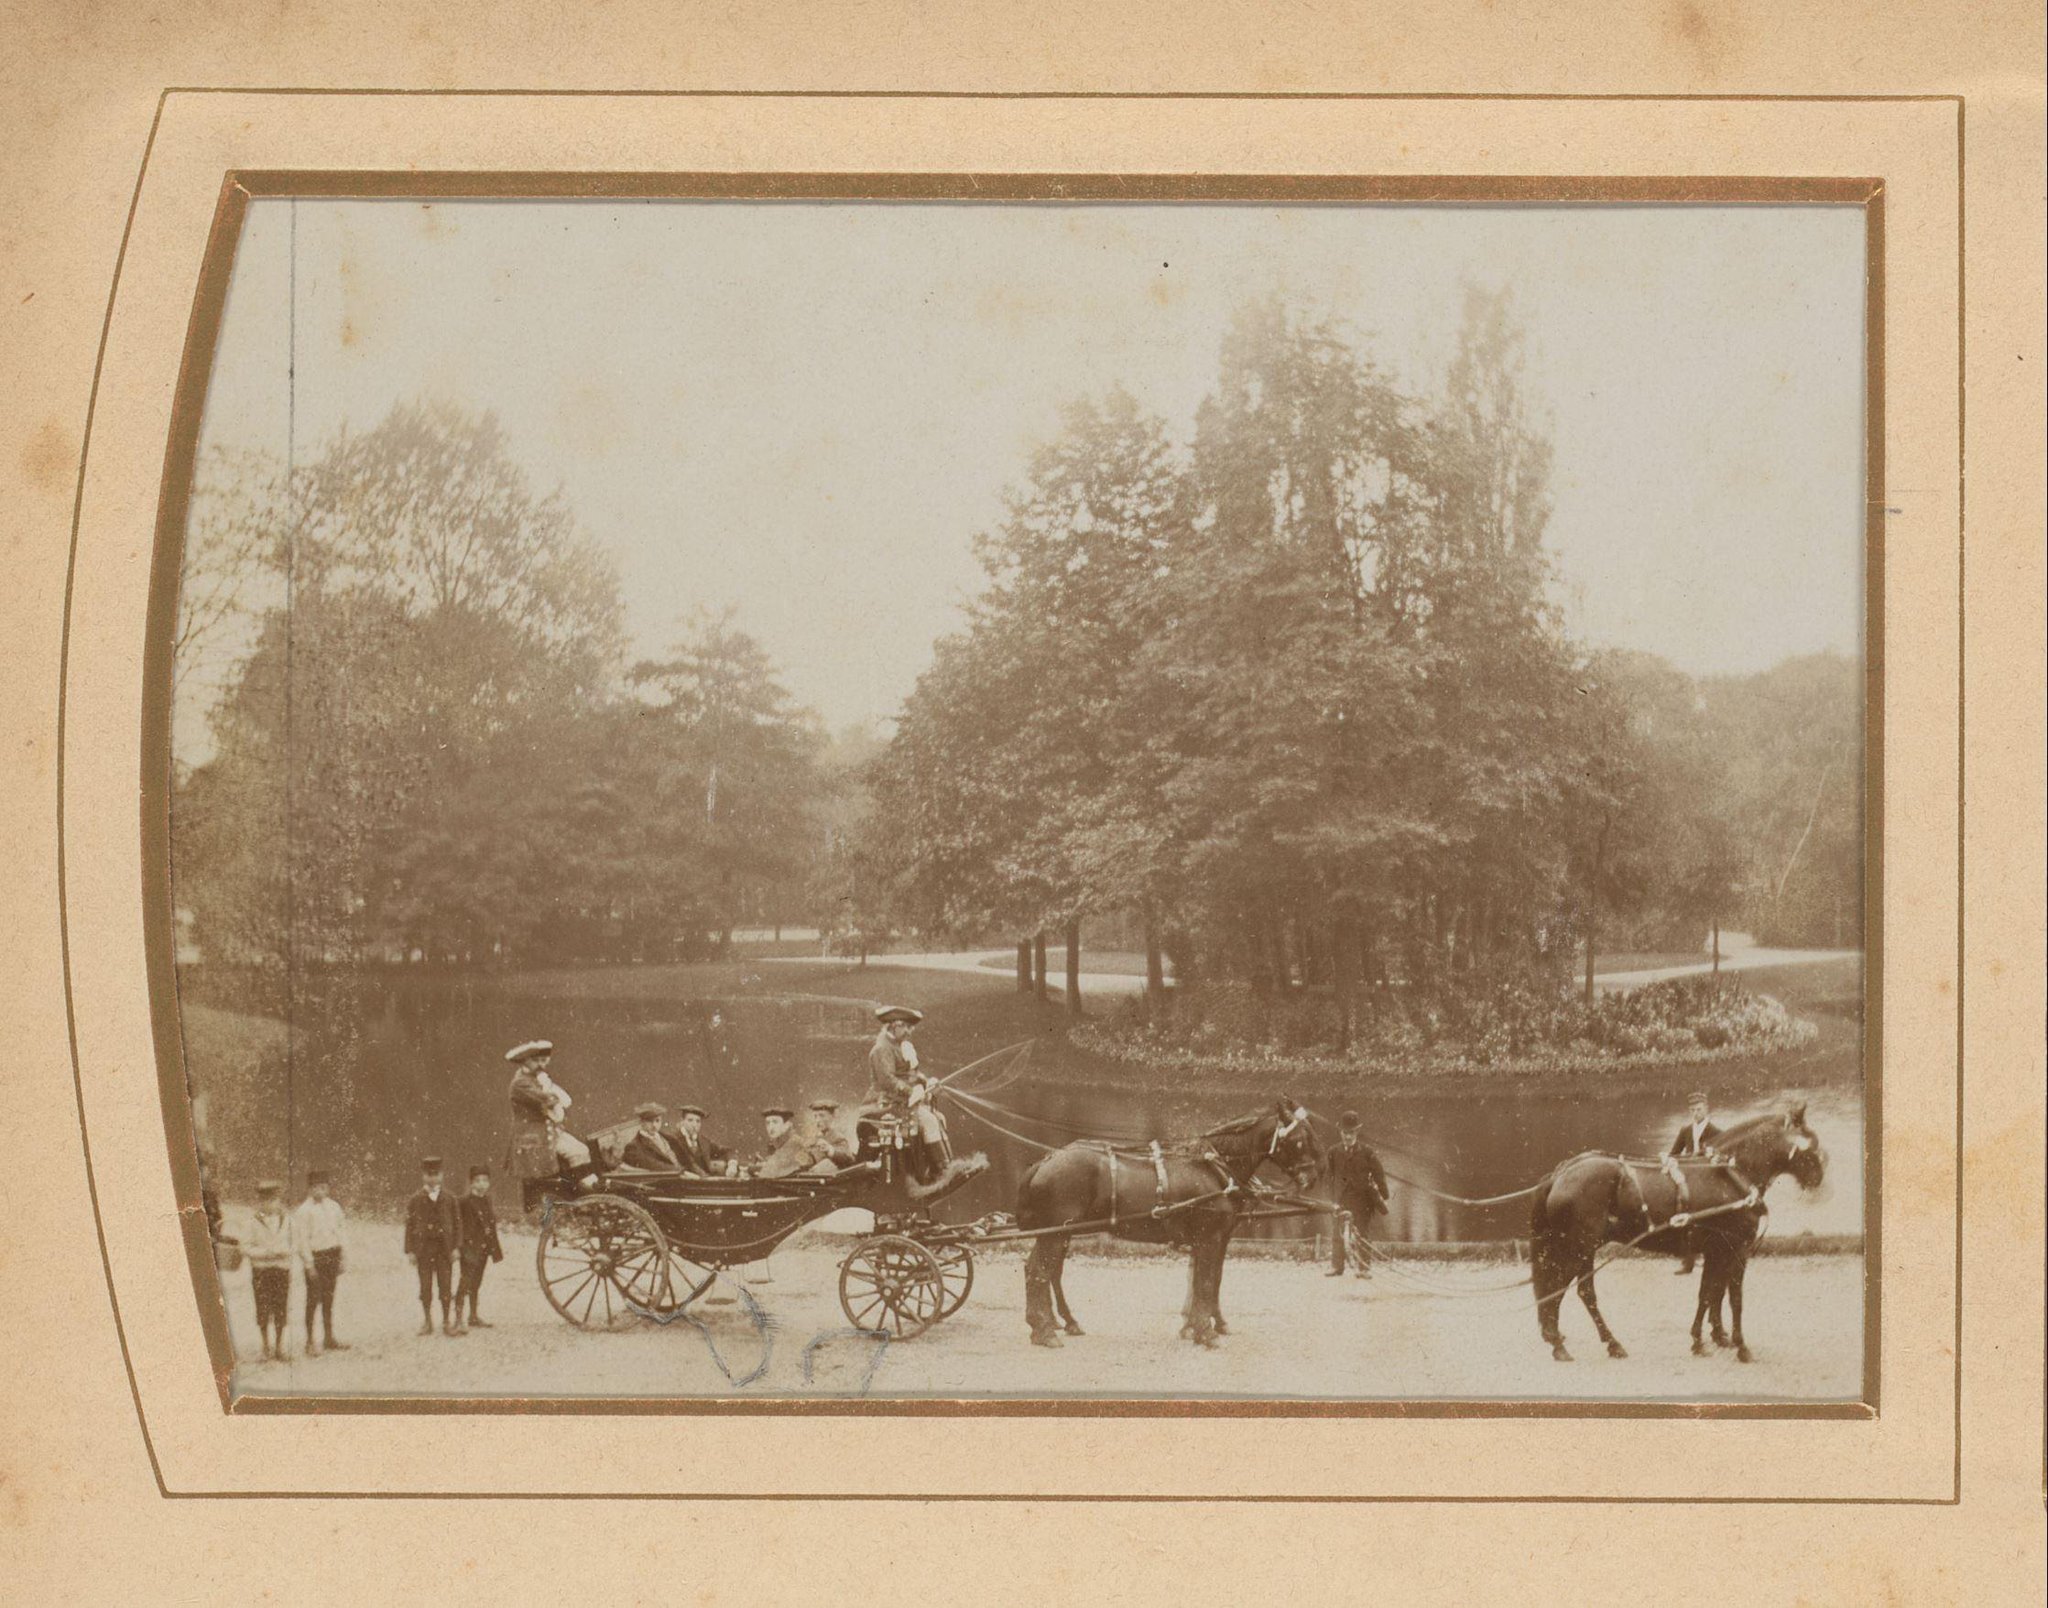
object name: photograph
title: Studenten in een rijtuig in het Vondelpark in Amsterdam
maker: Anonymous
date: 1880-1890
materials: cardboard, paper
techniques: albumen print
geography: amsterdam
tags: four-wheeled, animal-drawn vehicle, e.g.: cab, carriage, coach, student life